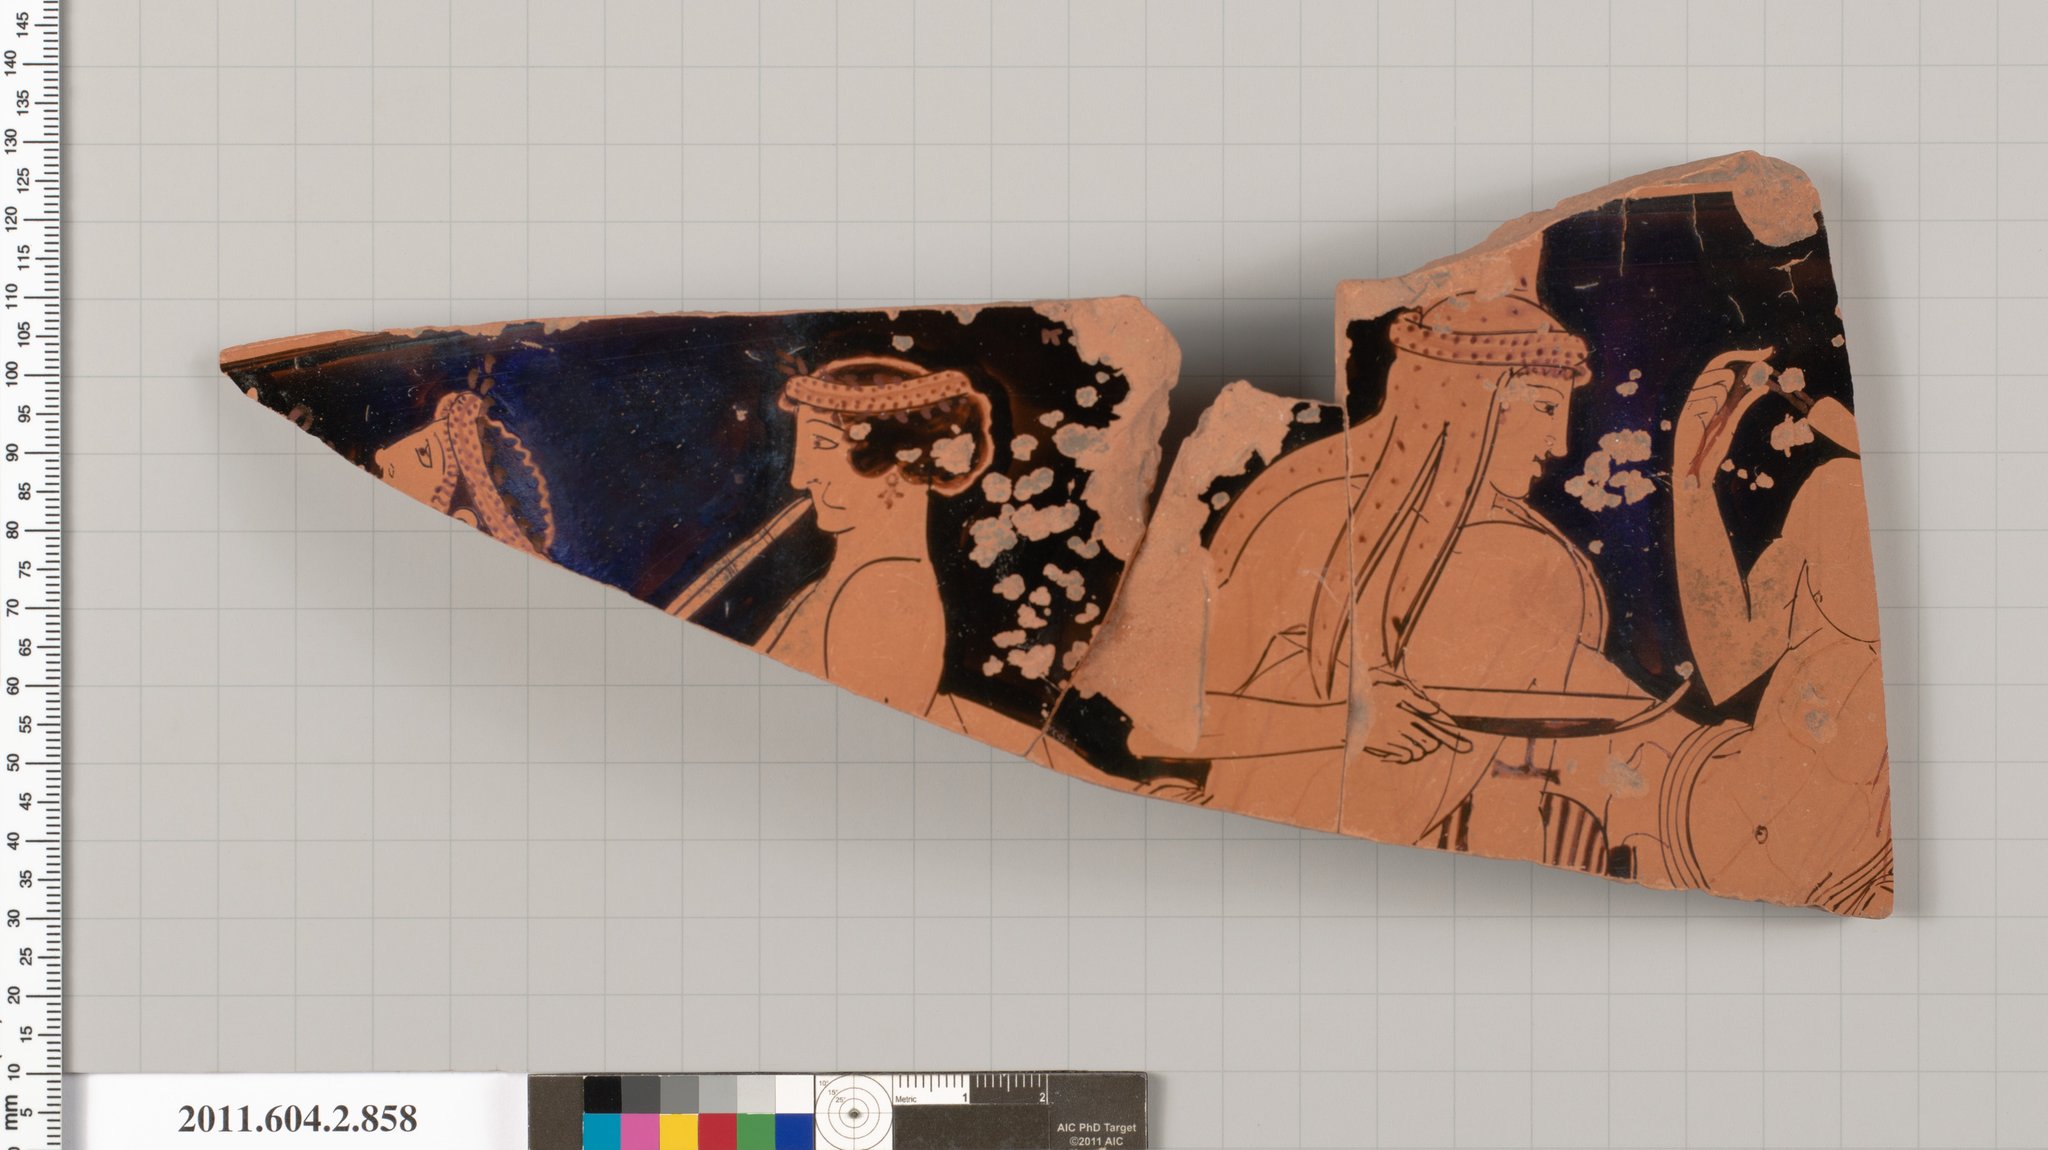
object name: bell krater fragment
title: Terracotta fragment of a bell-krater (bowl for mixing wine and water)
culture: greek, attic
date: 470-460 BCE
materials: terracotta